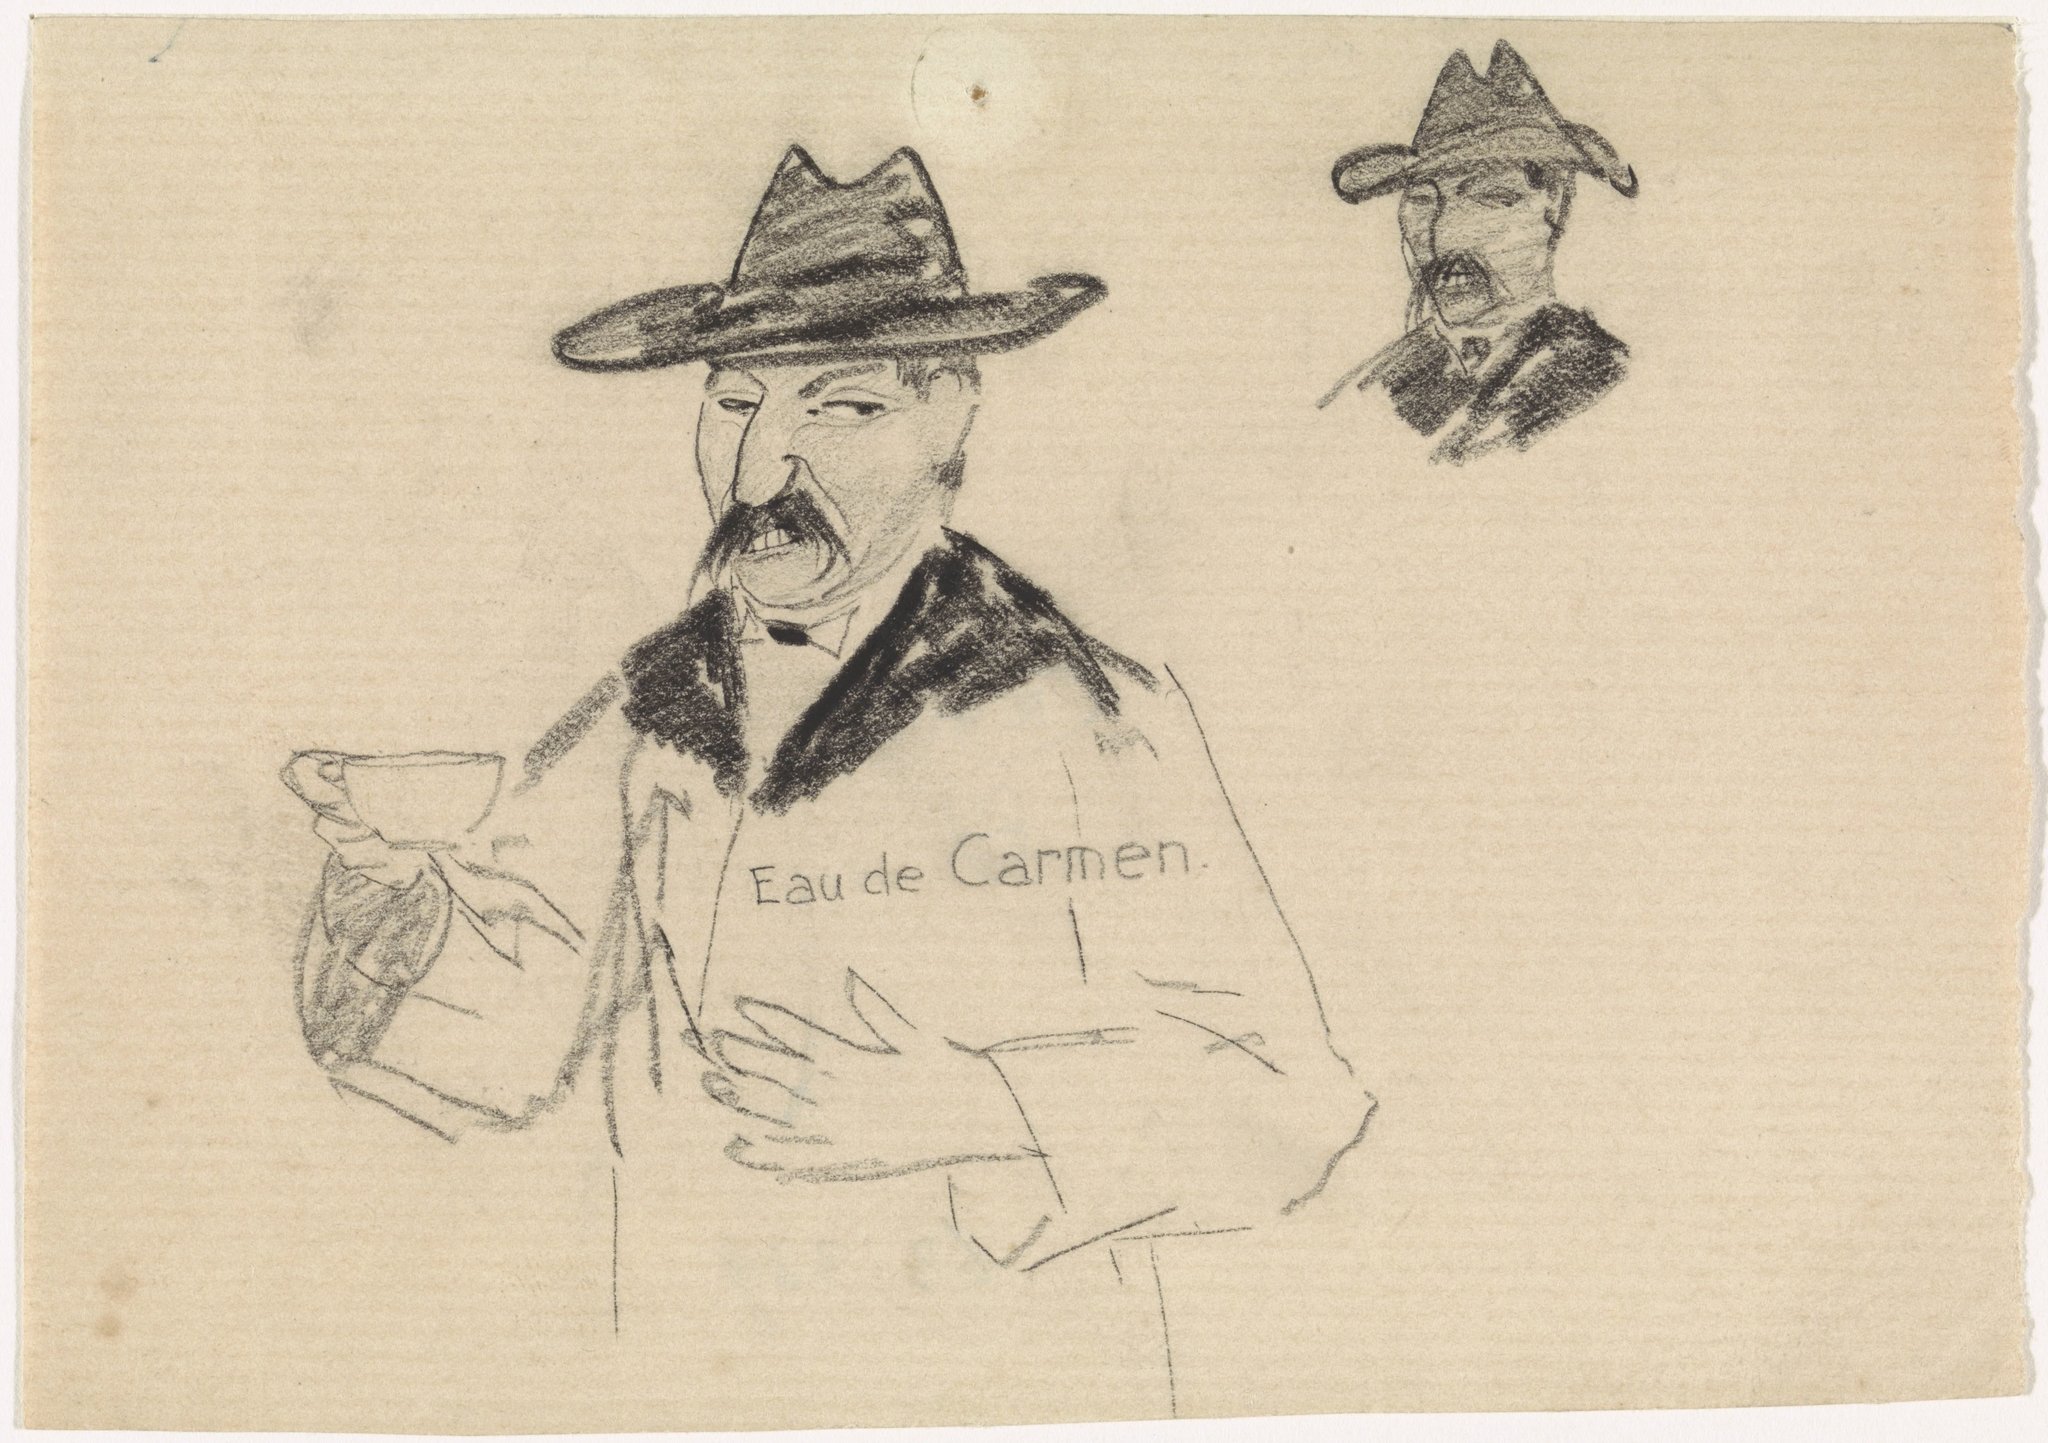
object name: drawing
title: Man met een theekopje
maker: gerrit willem dijsselhof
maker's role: designer, draughtsman, print maker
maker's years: 1866-1924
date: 1876-1924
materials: chalk, paper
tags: caricatures (human types)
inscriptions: inscription: ‘Eau de Carmen’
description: Een joods type met een kopje in de hand; het hoofd nog eens geschetst.